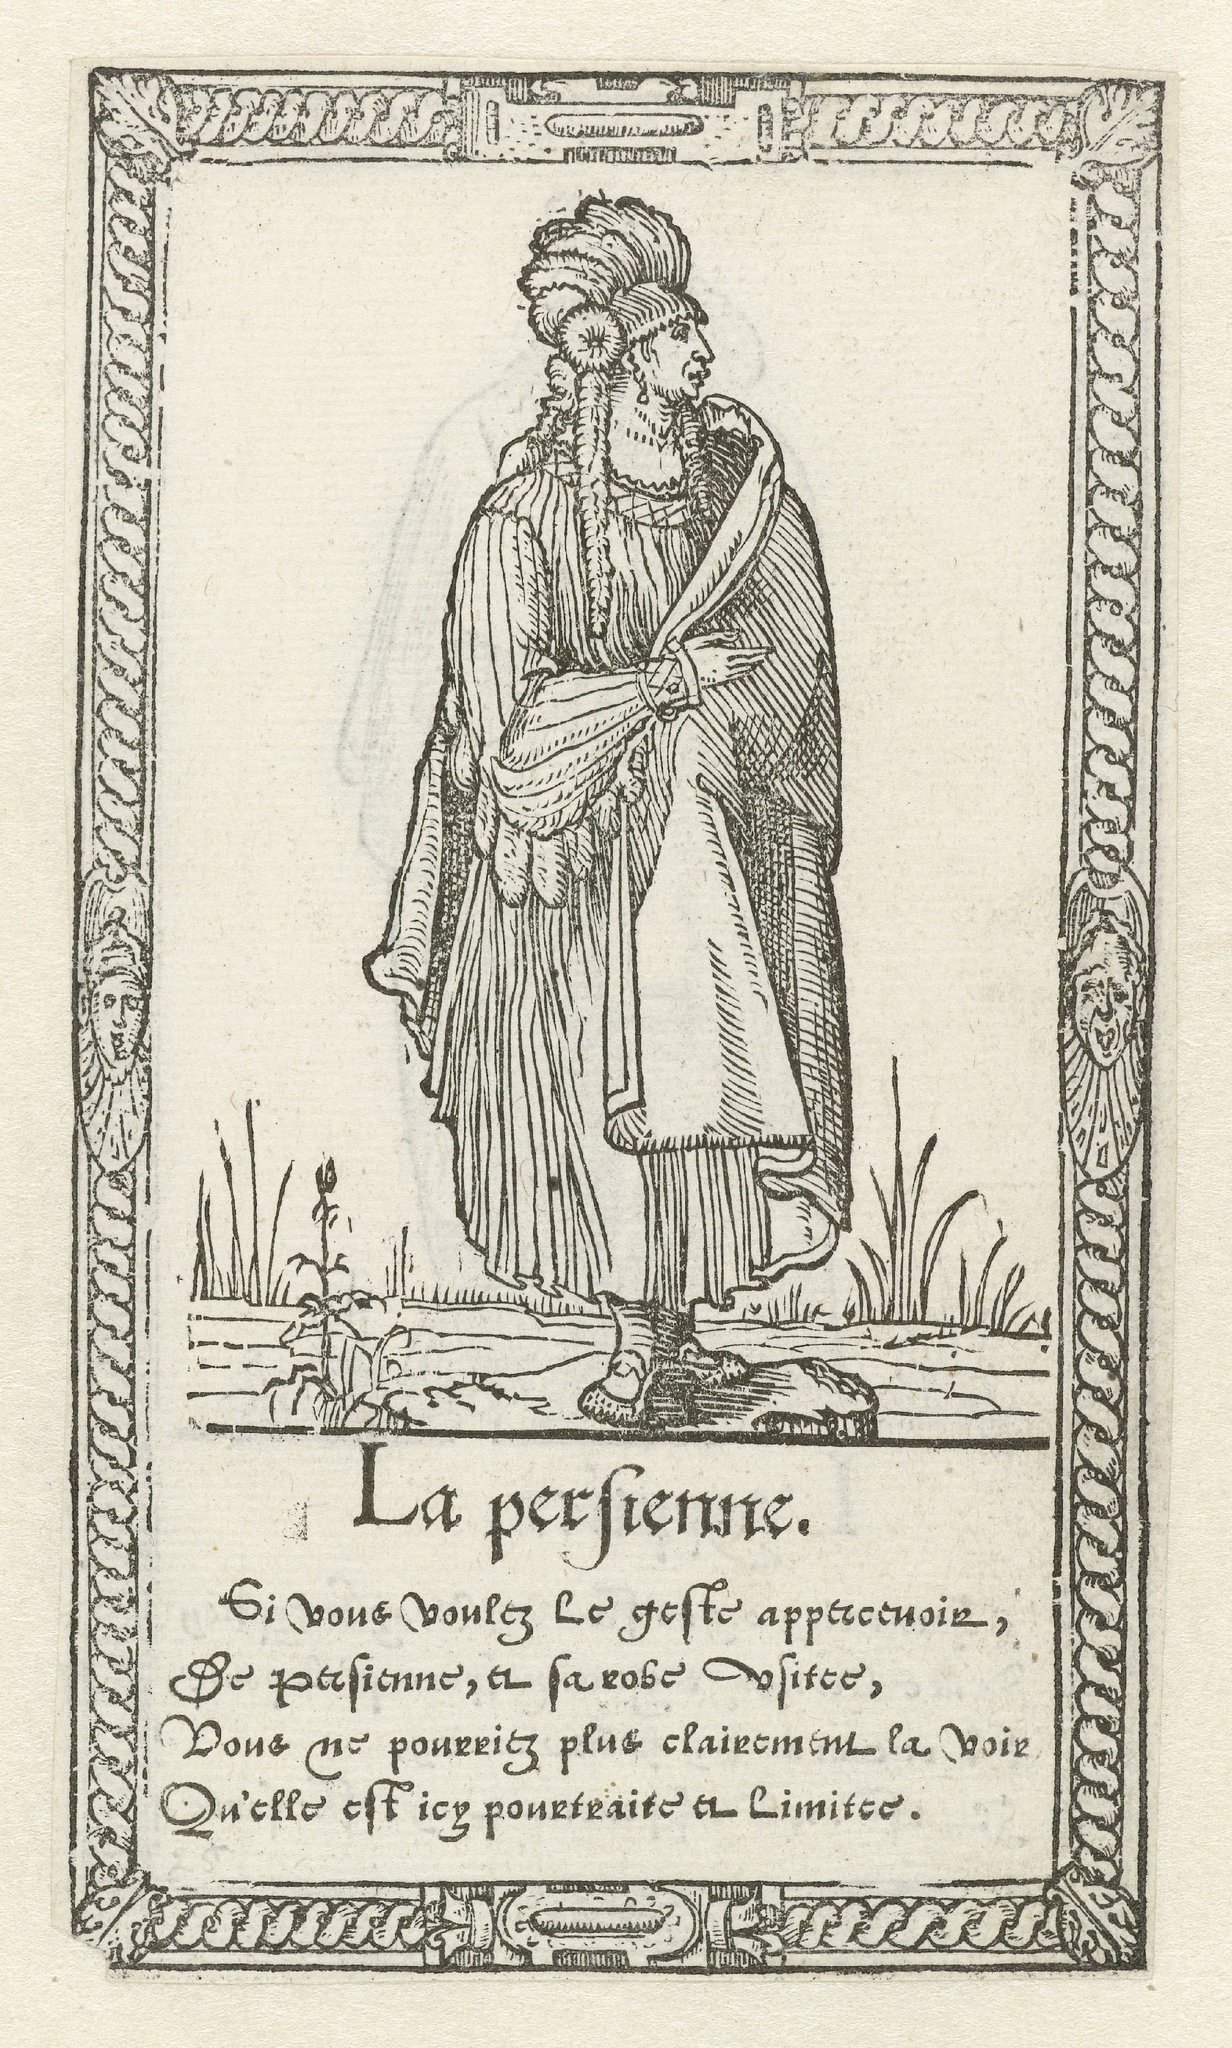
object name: print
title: Recueil de la diversité des habits (A Collection of the Various Styles of Clothing)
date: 1562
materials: paper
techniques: woodcut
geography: paris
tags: fashion plates, folk costume, regional costume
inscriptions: collector's mark: Lugt 2228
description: This is the very first costume book, with more than a hundred images of clothing from around the world. Below each figure are four lines of verse describing the country’s outfits or related customs. This was an age of unprecedented overseas exploration. Europeans were especially fascinated to see and read about inhabitants of the so-called New World, such as the Brazilian woman with her child 1.